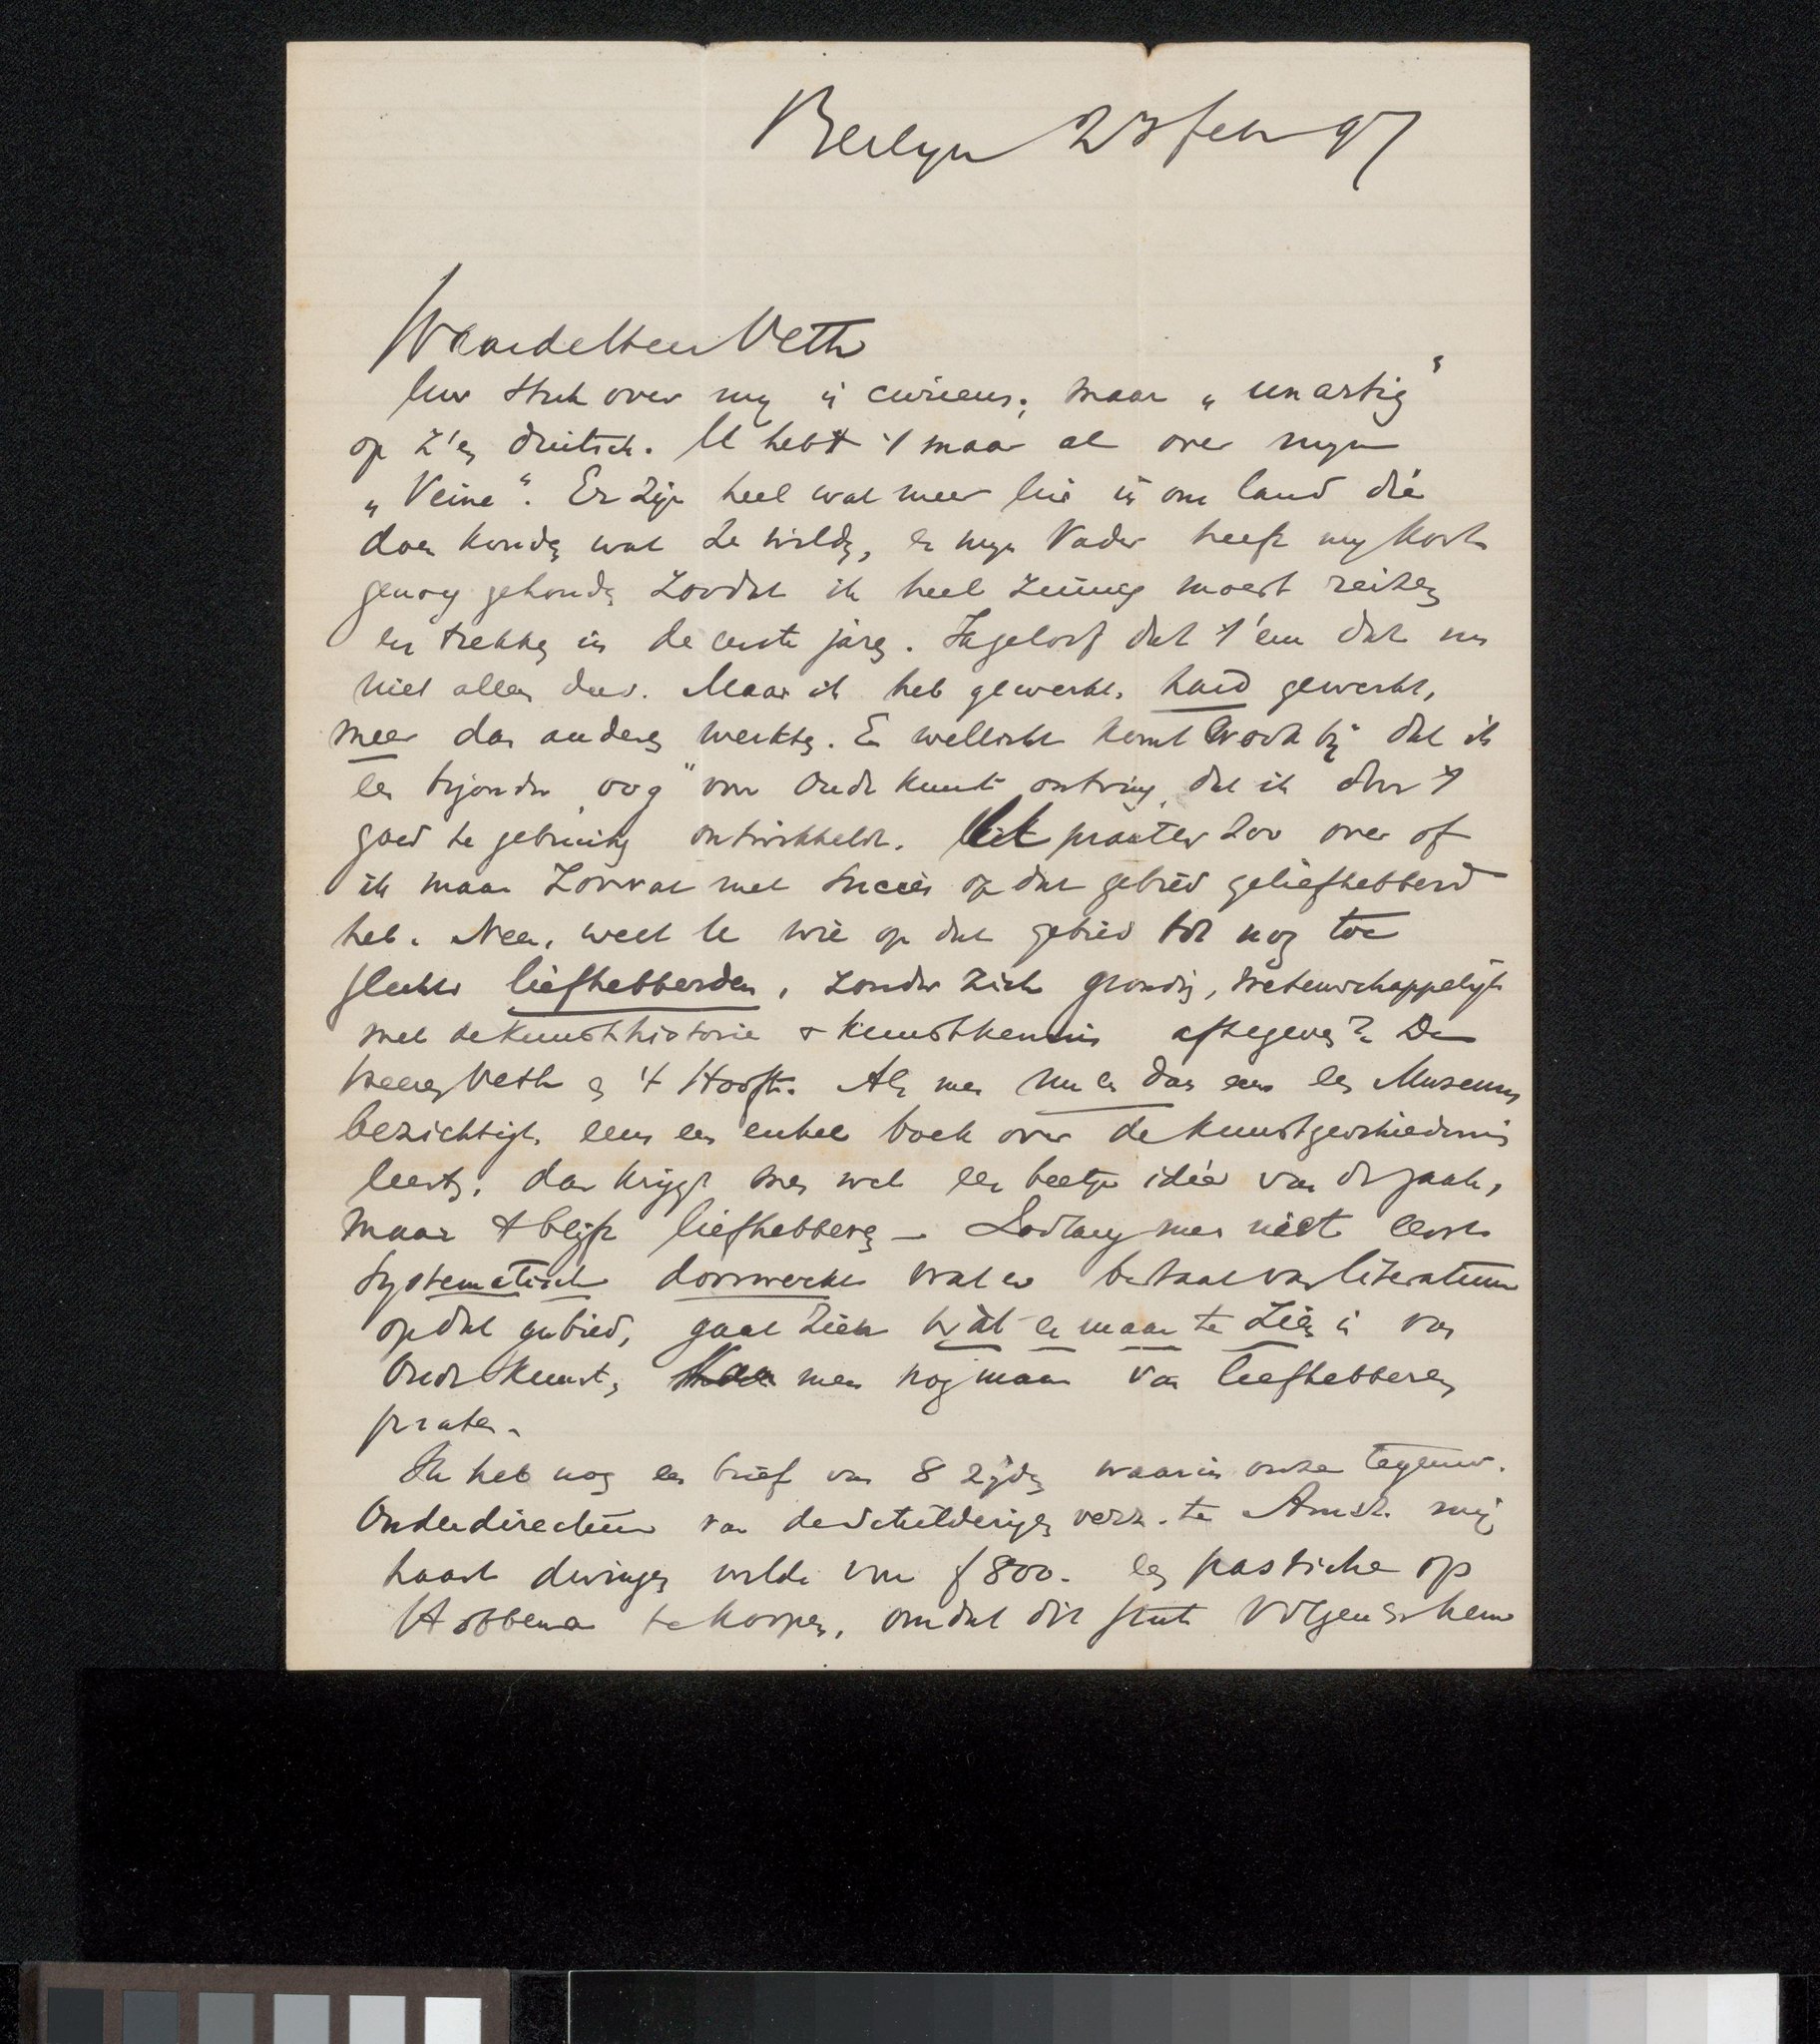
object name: letter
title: Brief aan Jan Veth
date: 1897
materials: ink, pencil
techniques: pen, writing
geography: berlin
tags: the hague, jozef israëls, dordrecht, designer, jan veth, haarlem, judith leyster, amsterdam, painter, meindert hobbema, lucas van leyden, berlin, print maker, draughtsman, max liebermann, leiden, rembrandt van rijn, politician, samuel van houten, cornelis hofstede de groot, wilhelm von bode, rijksmuseum amsterdam, painting (including book-illumination, miniature-painting), money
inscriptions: collector's mark: ‘RPK’